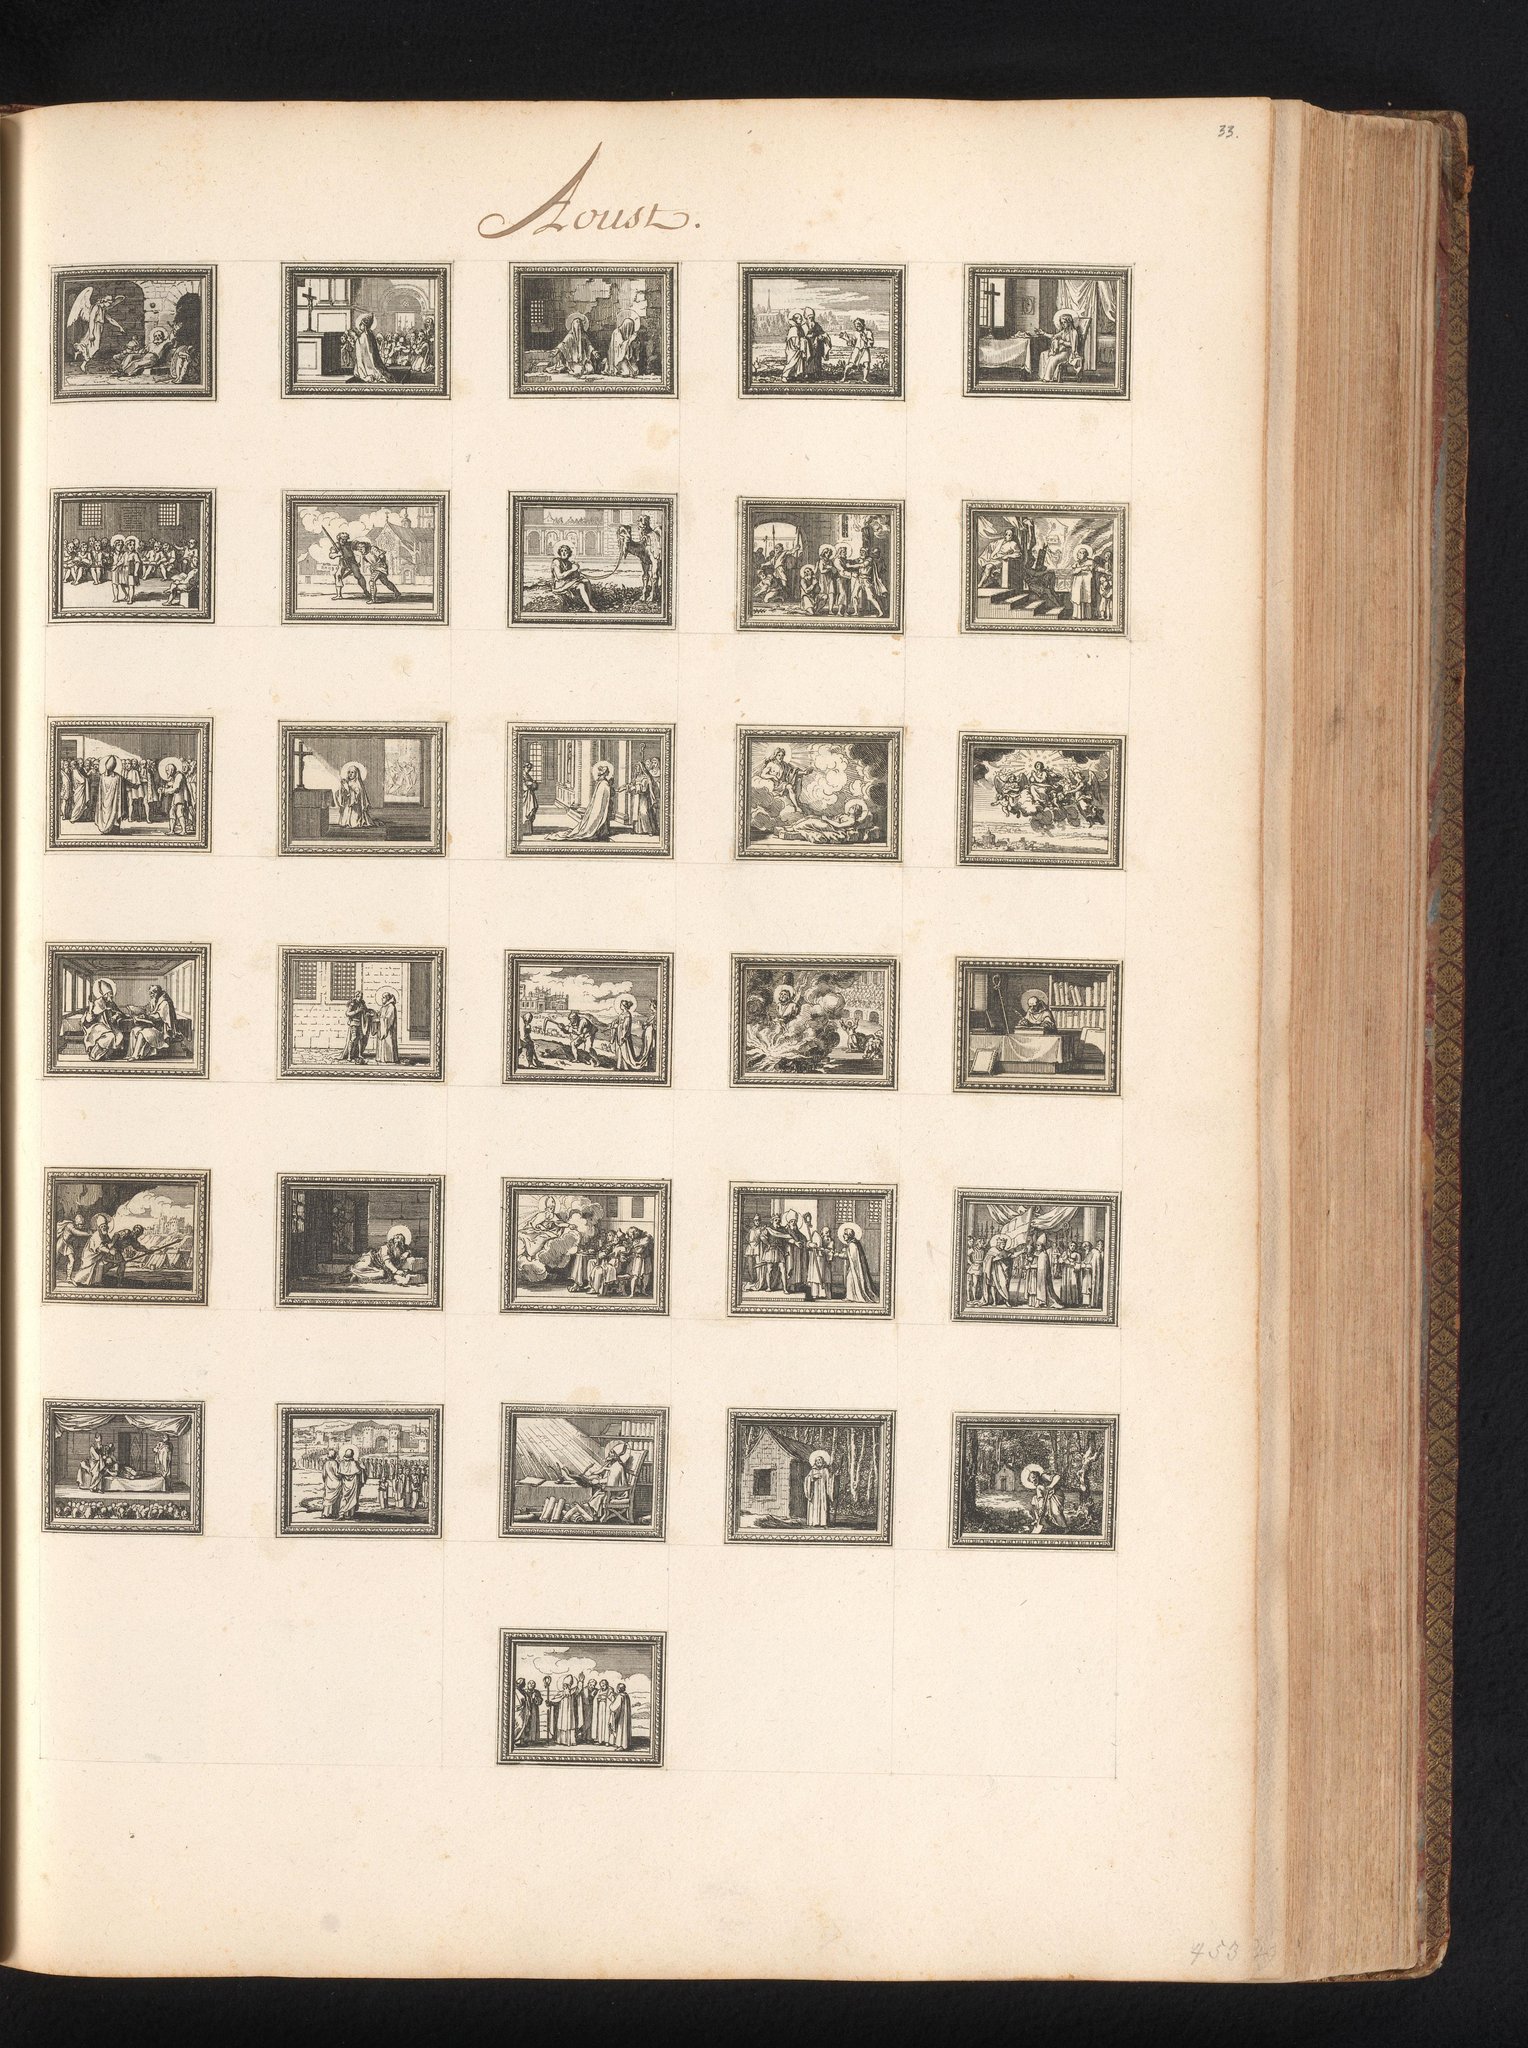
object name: print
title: Heiligen van de maand augustus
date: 1687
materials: ink, paper, pencil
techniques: etching, pen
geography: paris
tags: saints, august ~ other concepts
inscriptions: inscription: ‘Aoust.’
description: Prenten gebruikt voor: Giraud, L'Abbé. L'invocation et l'imitation des saints pour tous les jours de l'année. Parijs: Gérard Audran, 1687, 4 vols. Deze prenten staan ook wel bekend als de 'Saints d'Audran', zie IFF 17e siècle dl. 9, p. 118-119, nr. 1796-2174.